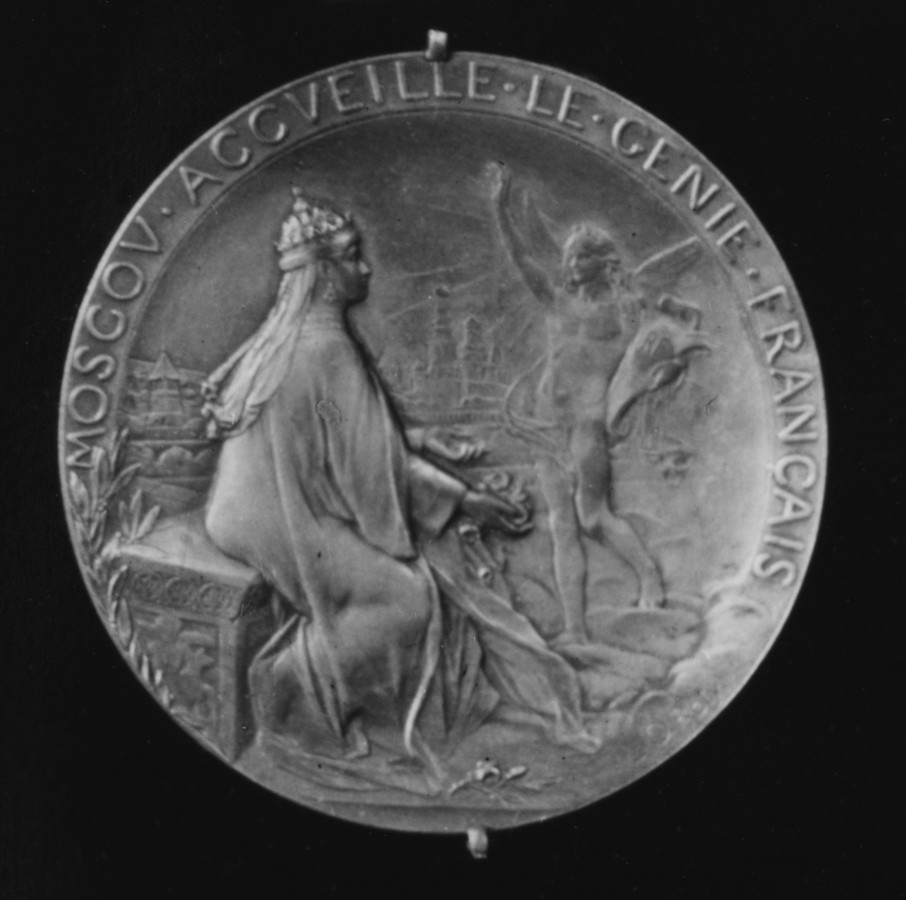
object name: medal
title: Exposition Francaise de Moscow, 1891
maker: louis-oscar roty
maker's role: artist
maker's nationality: french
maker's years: 1846-1911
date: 1891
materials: bronze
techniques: silvered, struck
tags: women